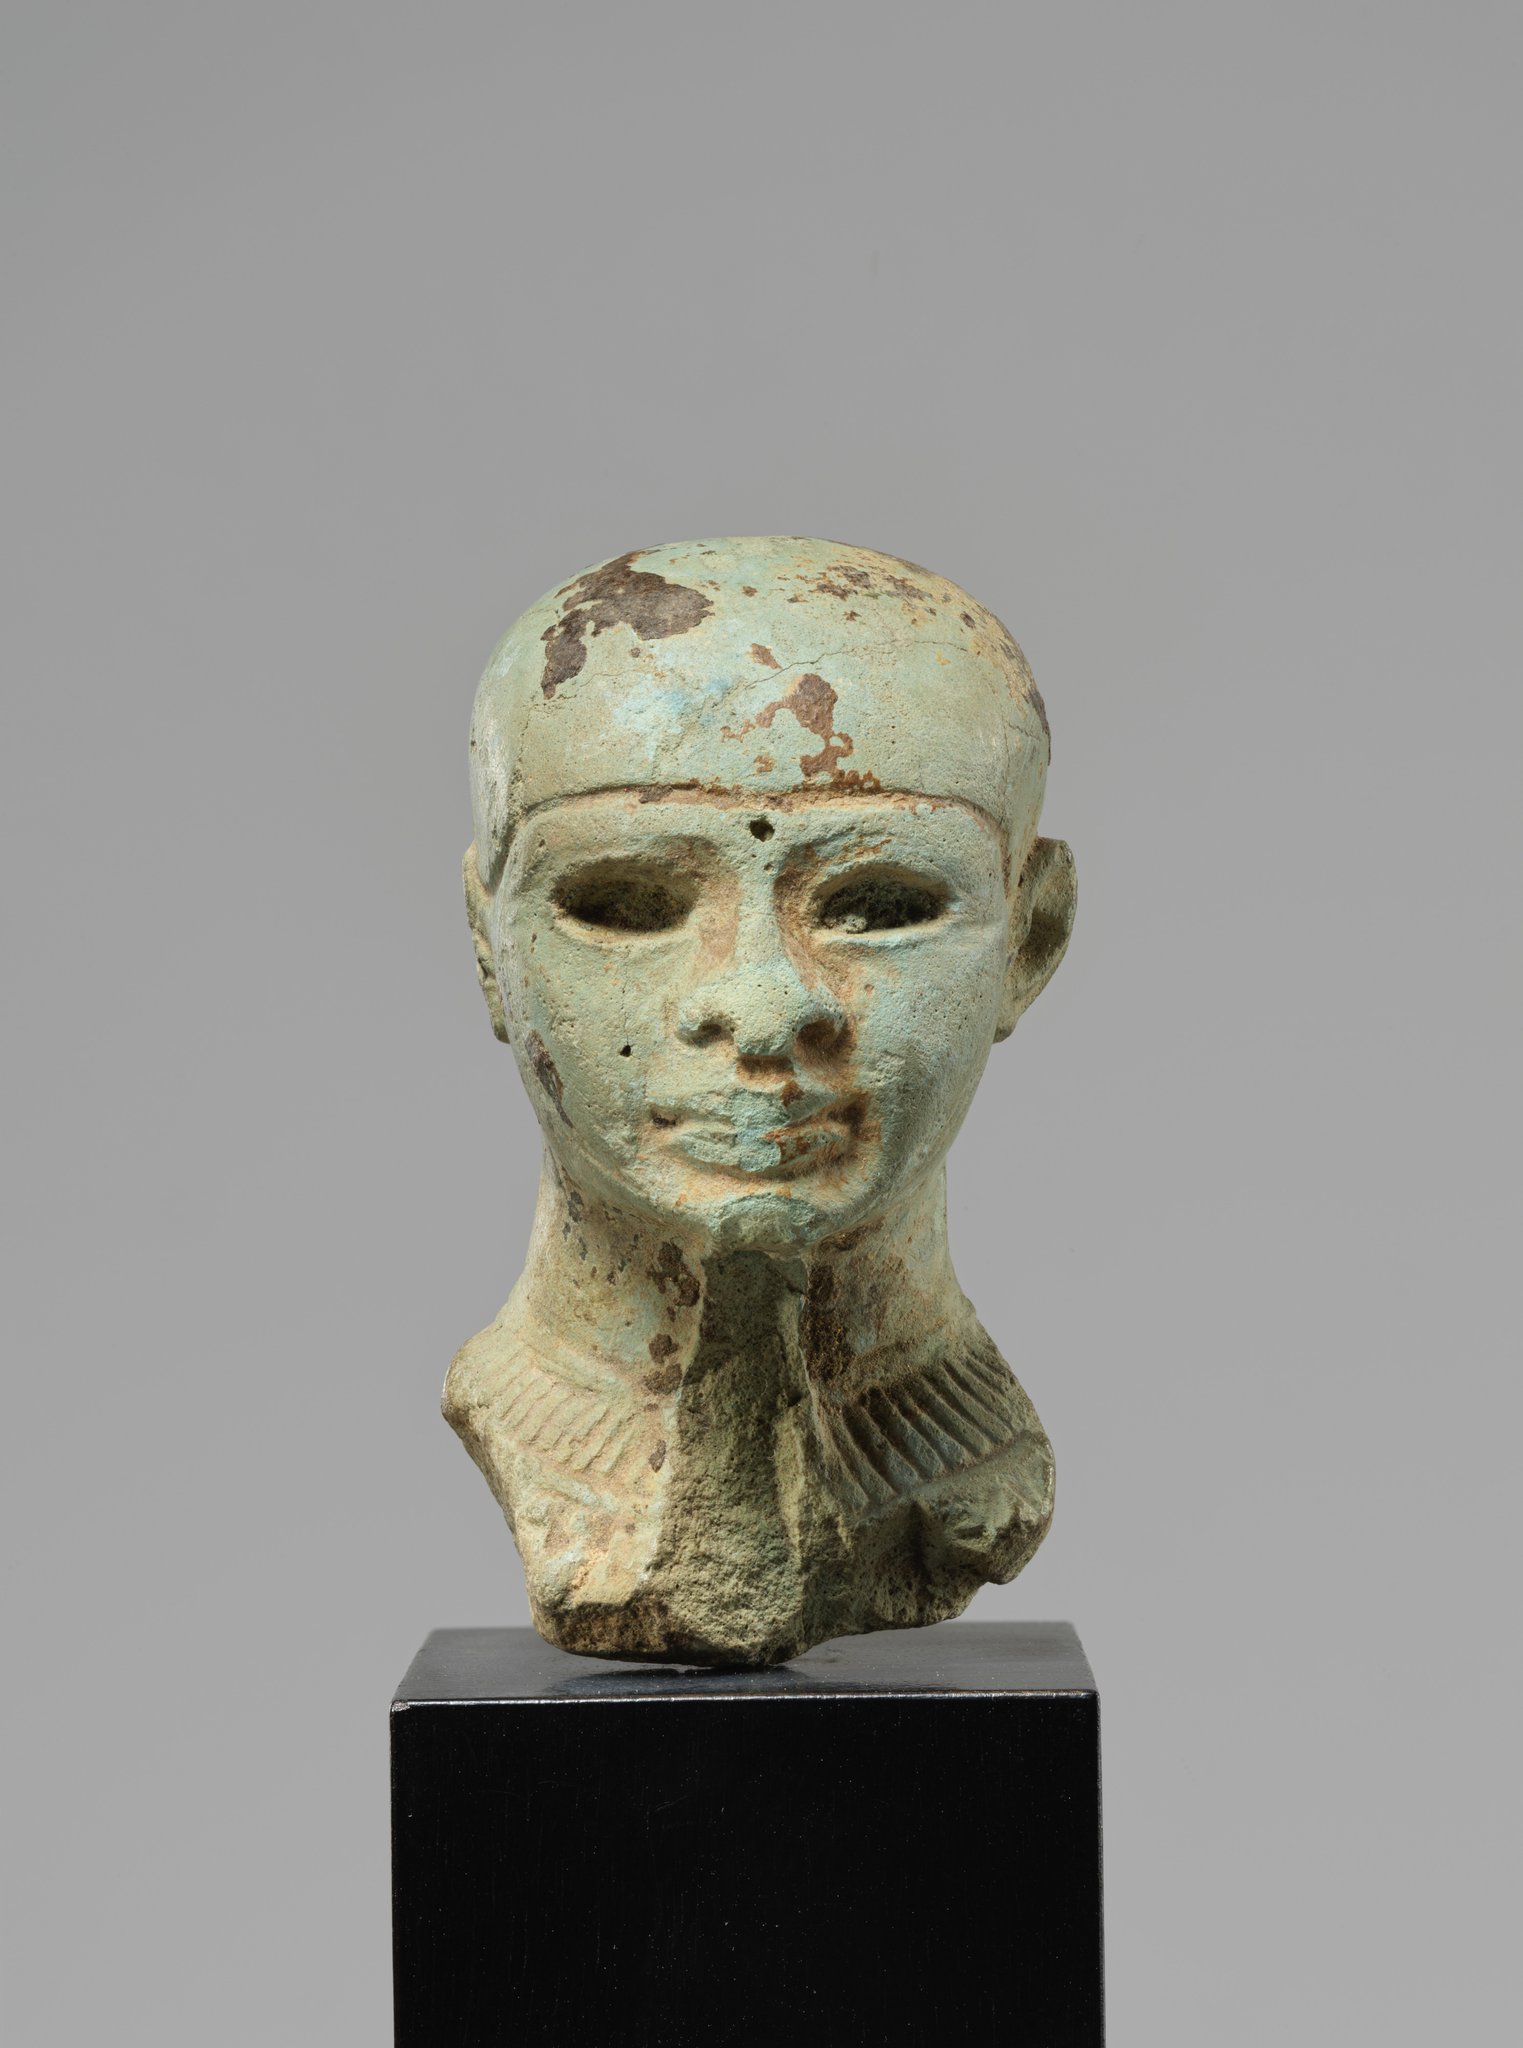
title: Head of Ptah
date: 1550-1070 BCE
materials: gold leaf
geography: egypt